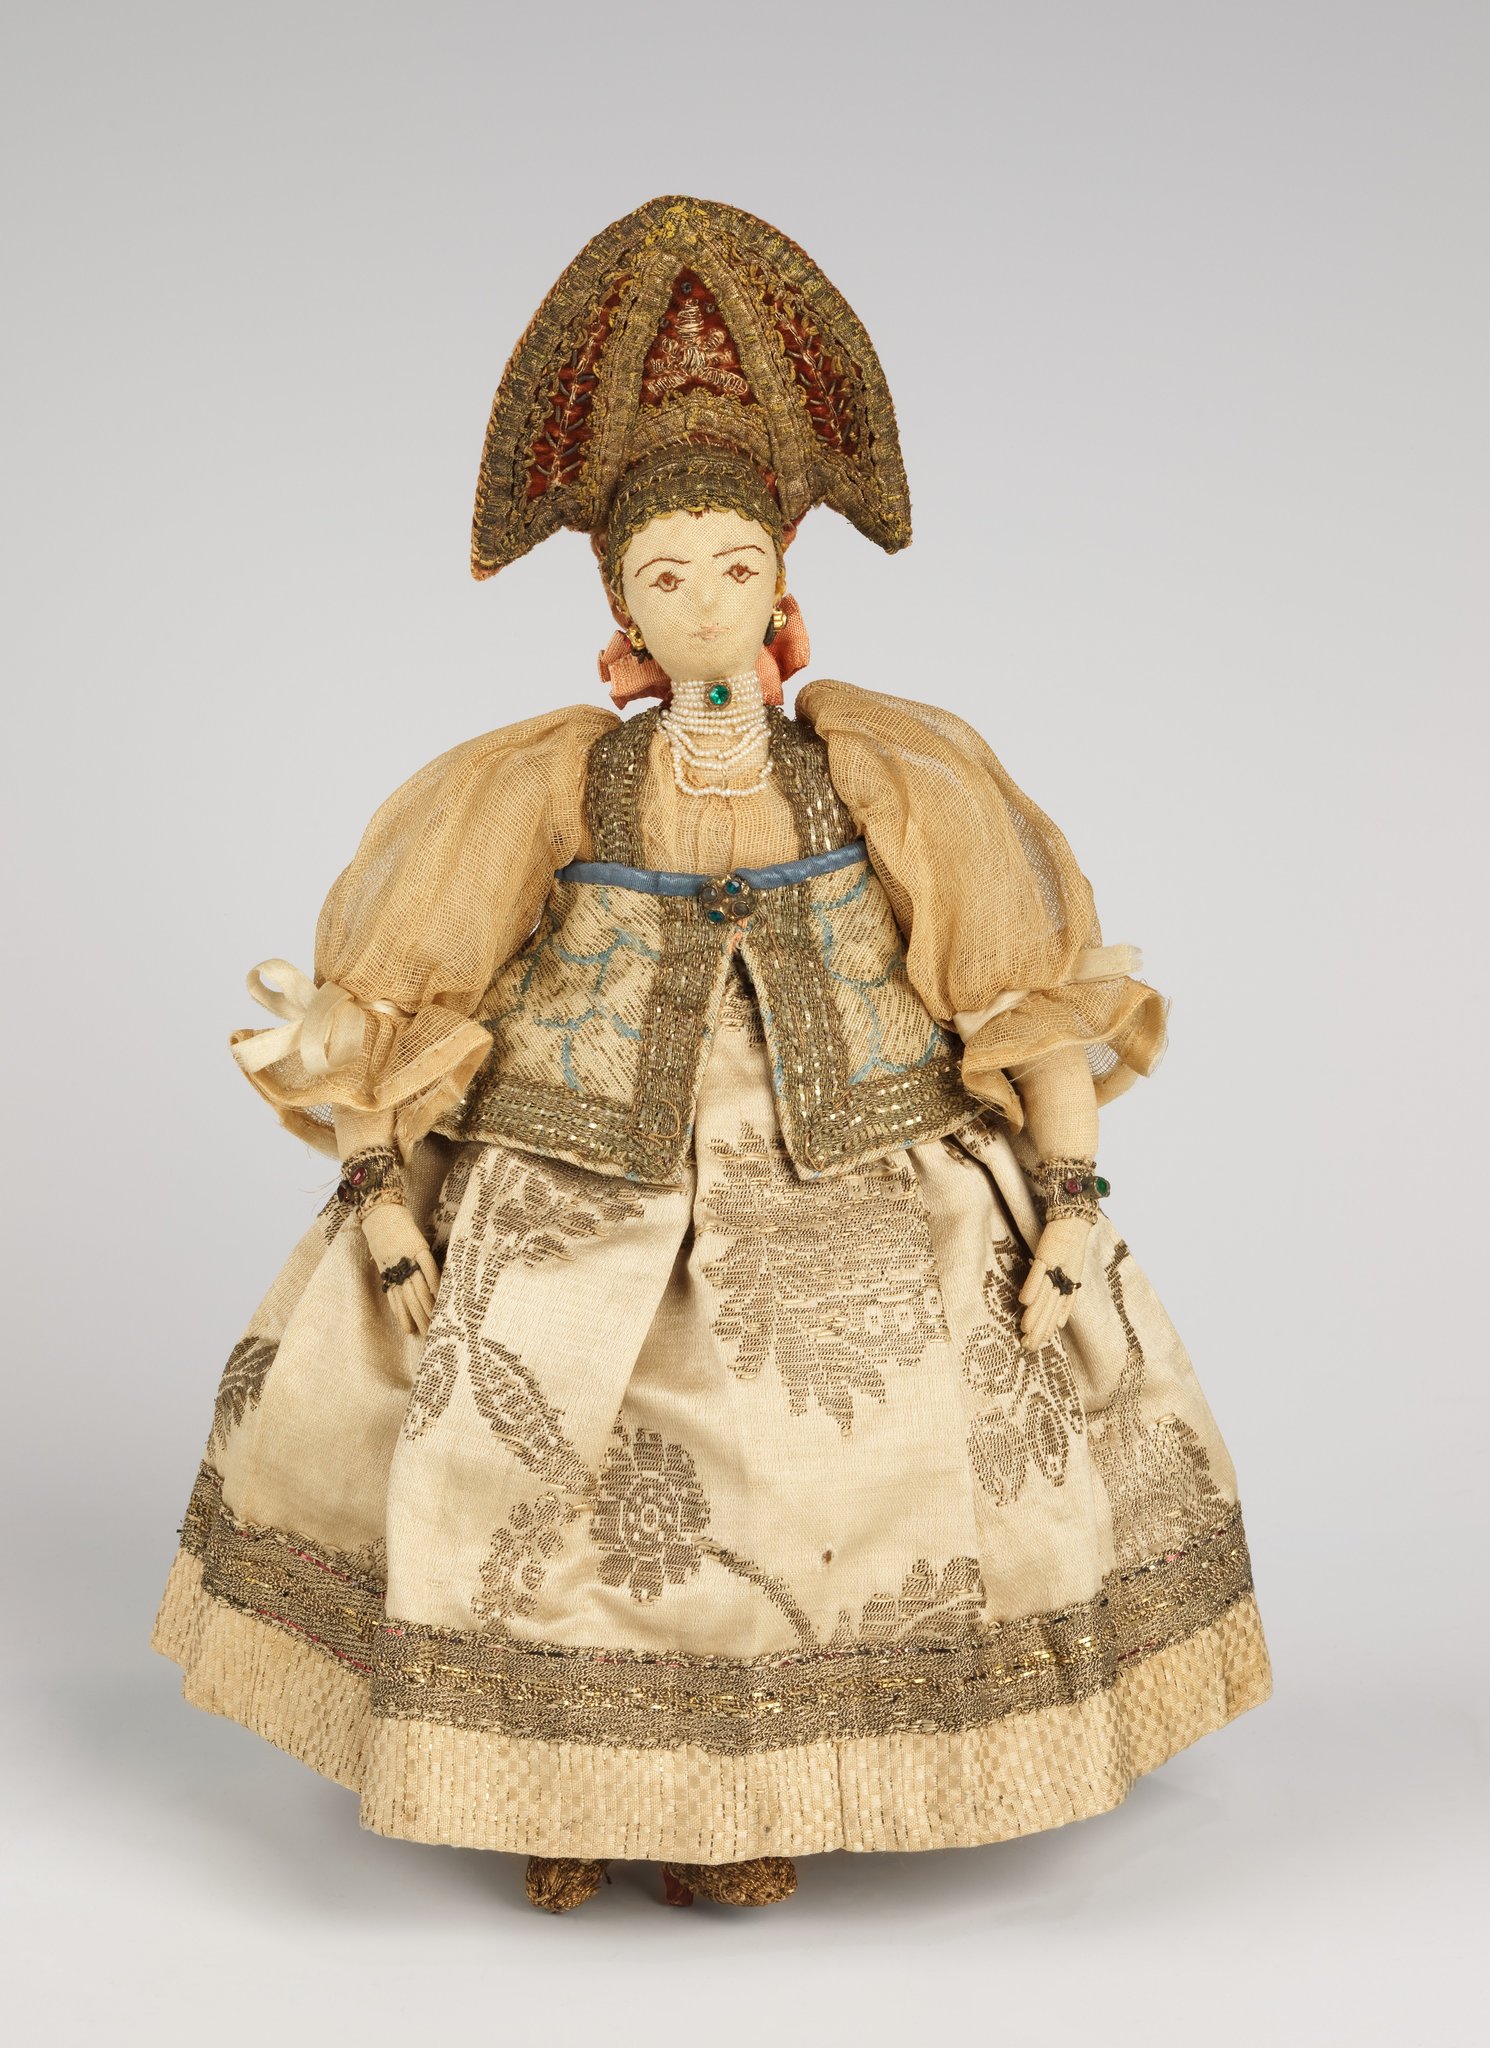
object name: doll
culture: russian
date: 1767-1800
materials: cotton, glass, linen, metal, pearl, silk, wood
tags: dolls,flowers